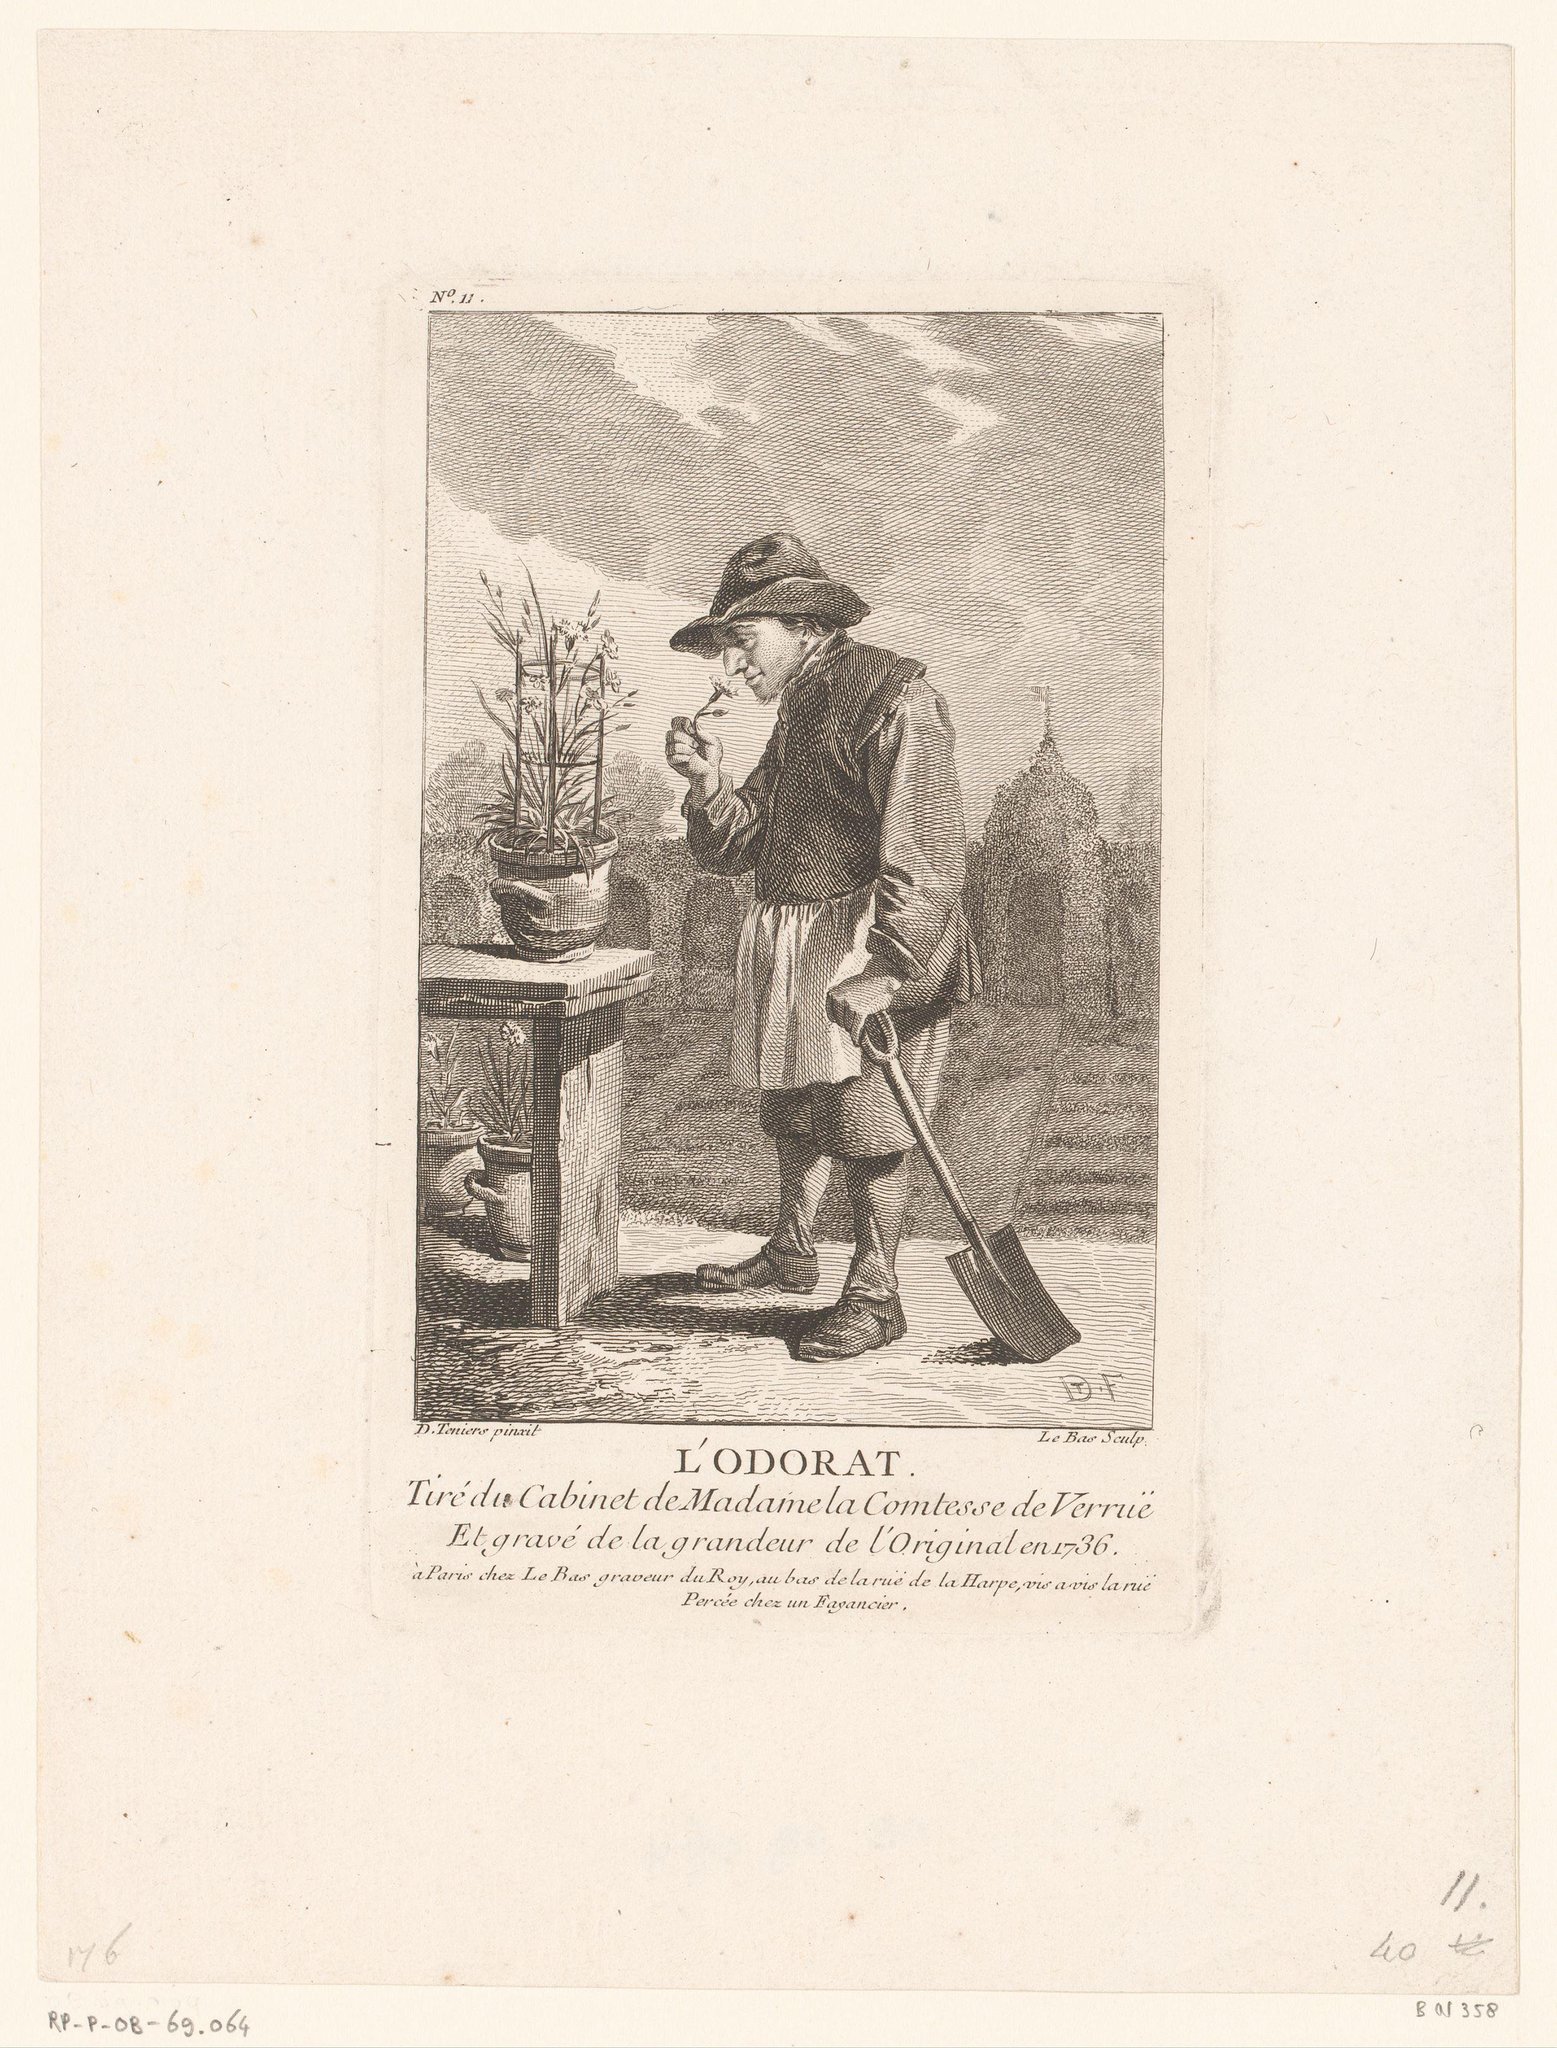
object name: print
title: Les Cinq Sens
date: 1736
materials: paper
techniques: etching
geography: paris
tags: smell, smelling (one of the five senses)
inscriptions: date